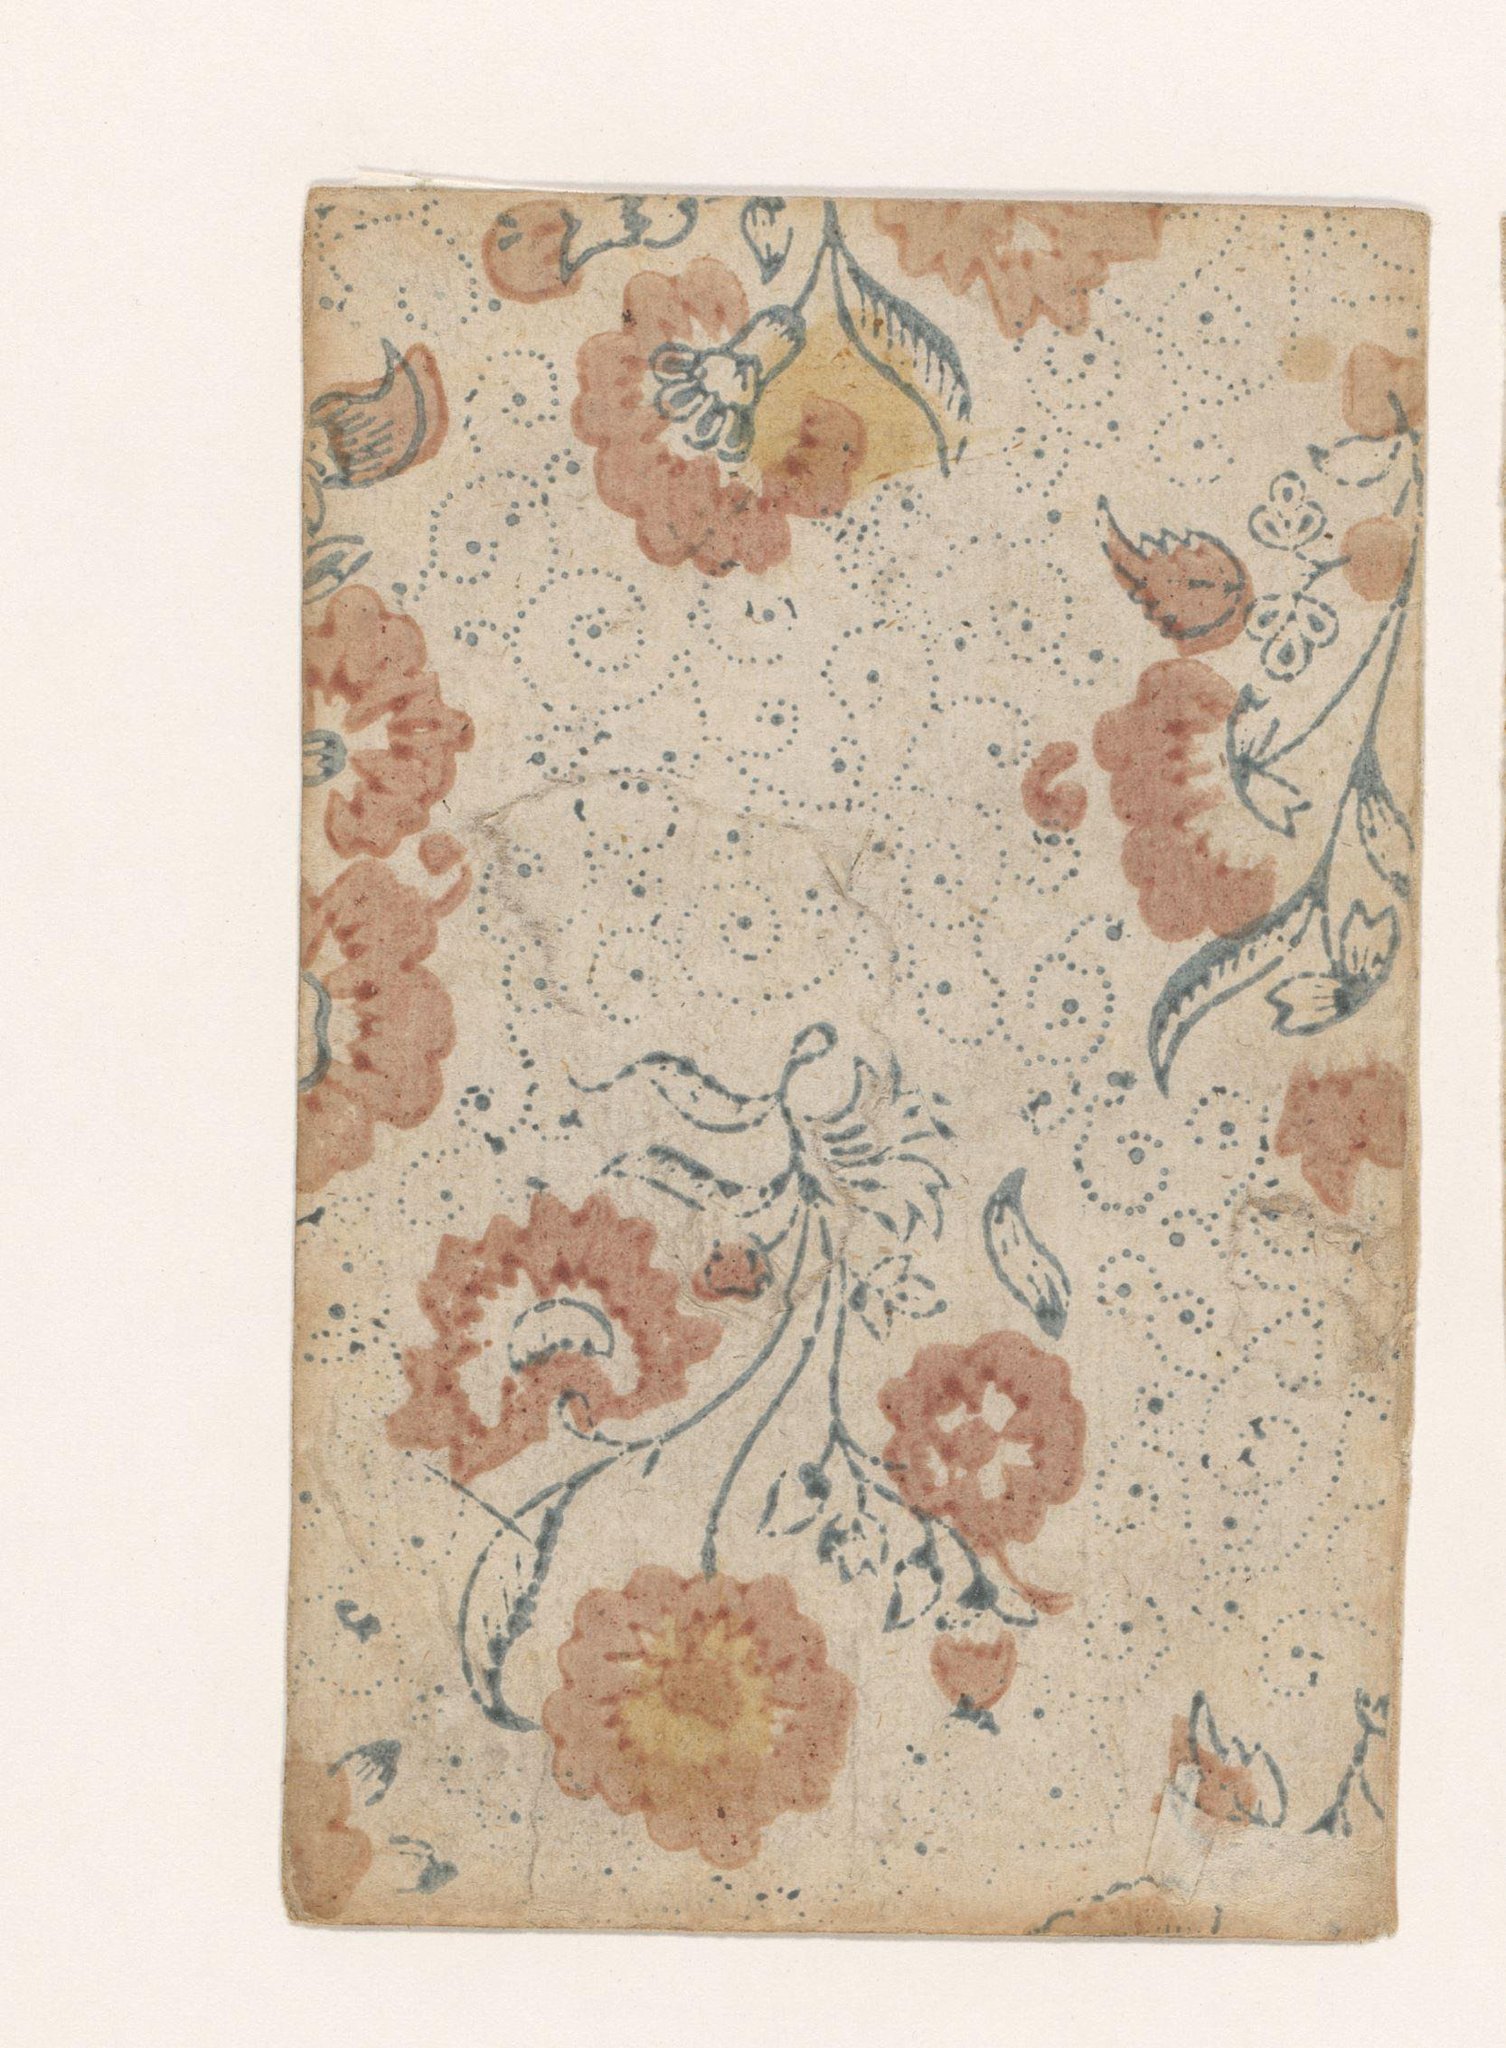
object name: wrapper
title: Blad met bloemen en stippenfond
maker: Anonymous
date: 1700-1850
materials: paper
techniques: printing block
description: Blad met losse bloemen en een fond van stippen in spiralen. Fragment van een omslag.